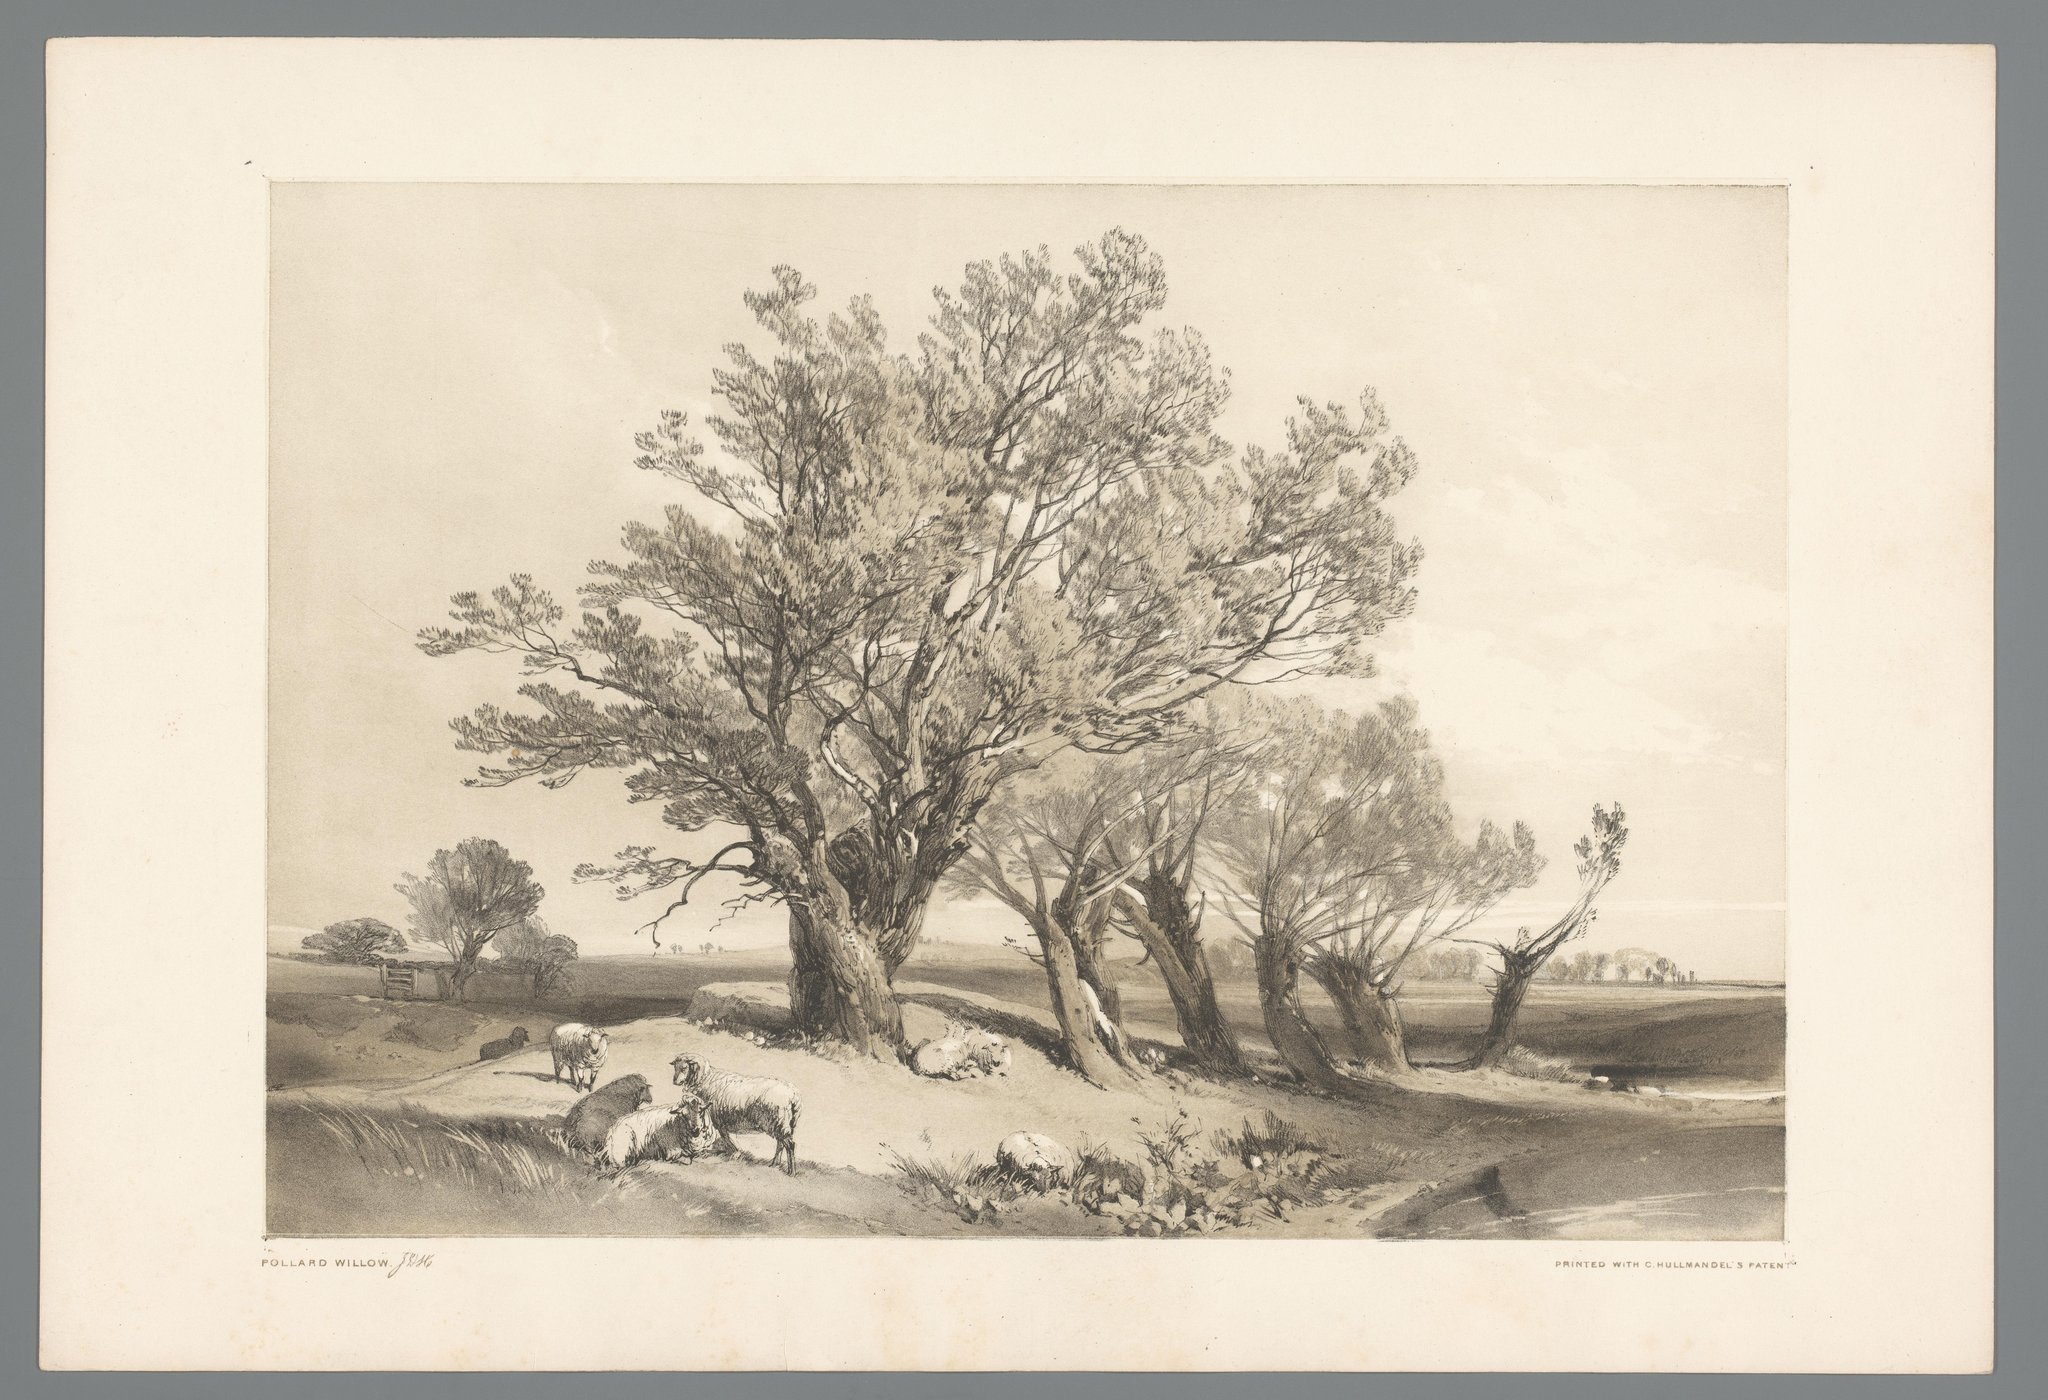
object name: print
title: Pollard Willow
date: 1841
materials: paper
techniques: tone lithography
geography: london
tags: park, forest, wood, sheep, meadow, pasture (+ landscape with figures, staffage)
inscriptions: collector's mark: Lugt 2760, collector's mark: Lugt 2228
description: Prent maakt deel uit van een serie van 24 prenten.